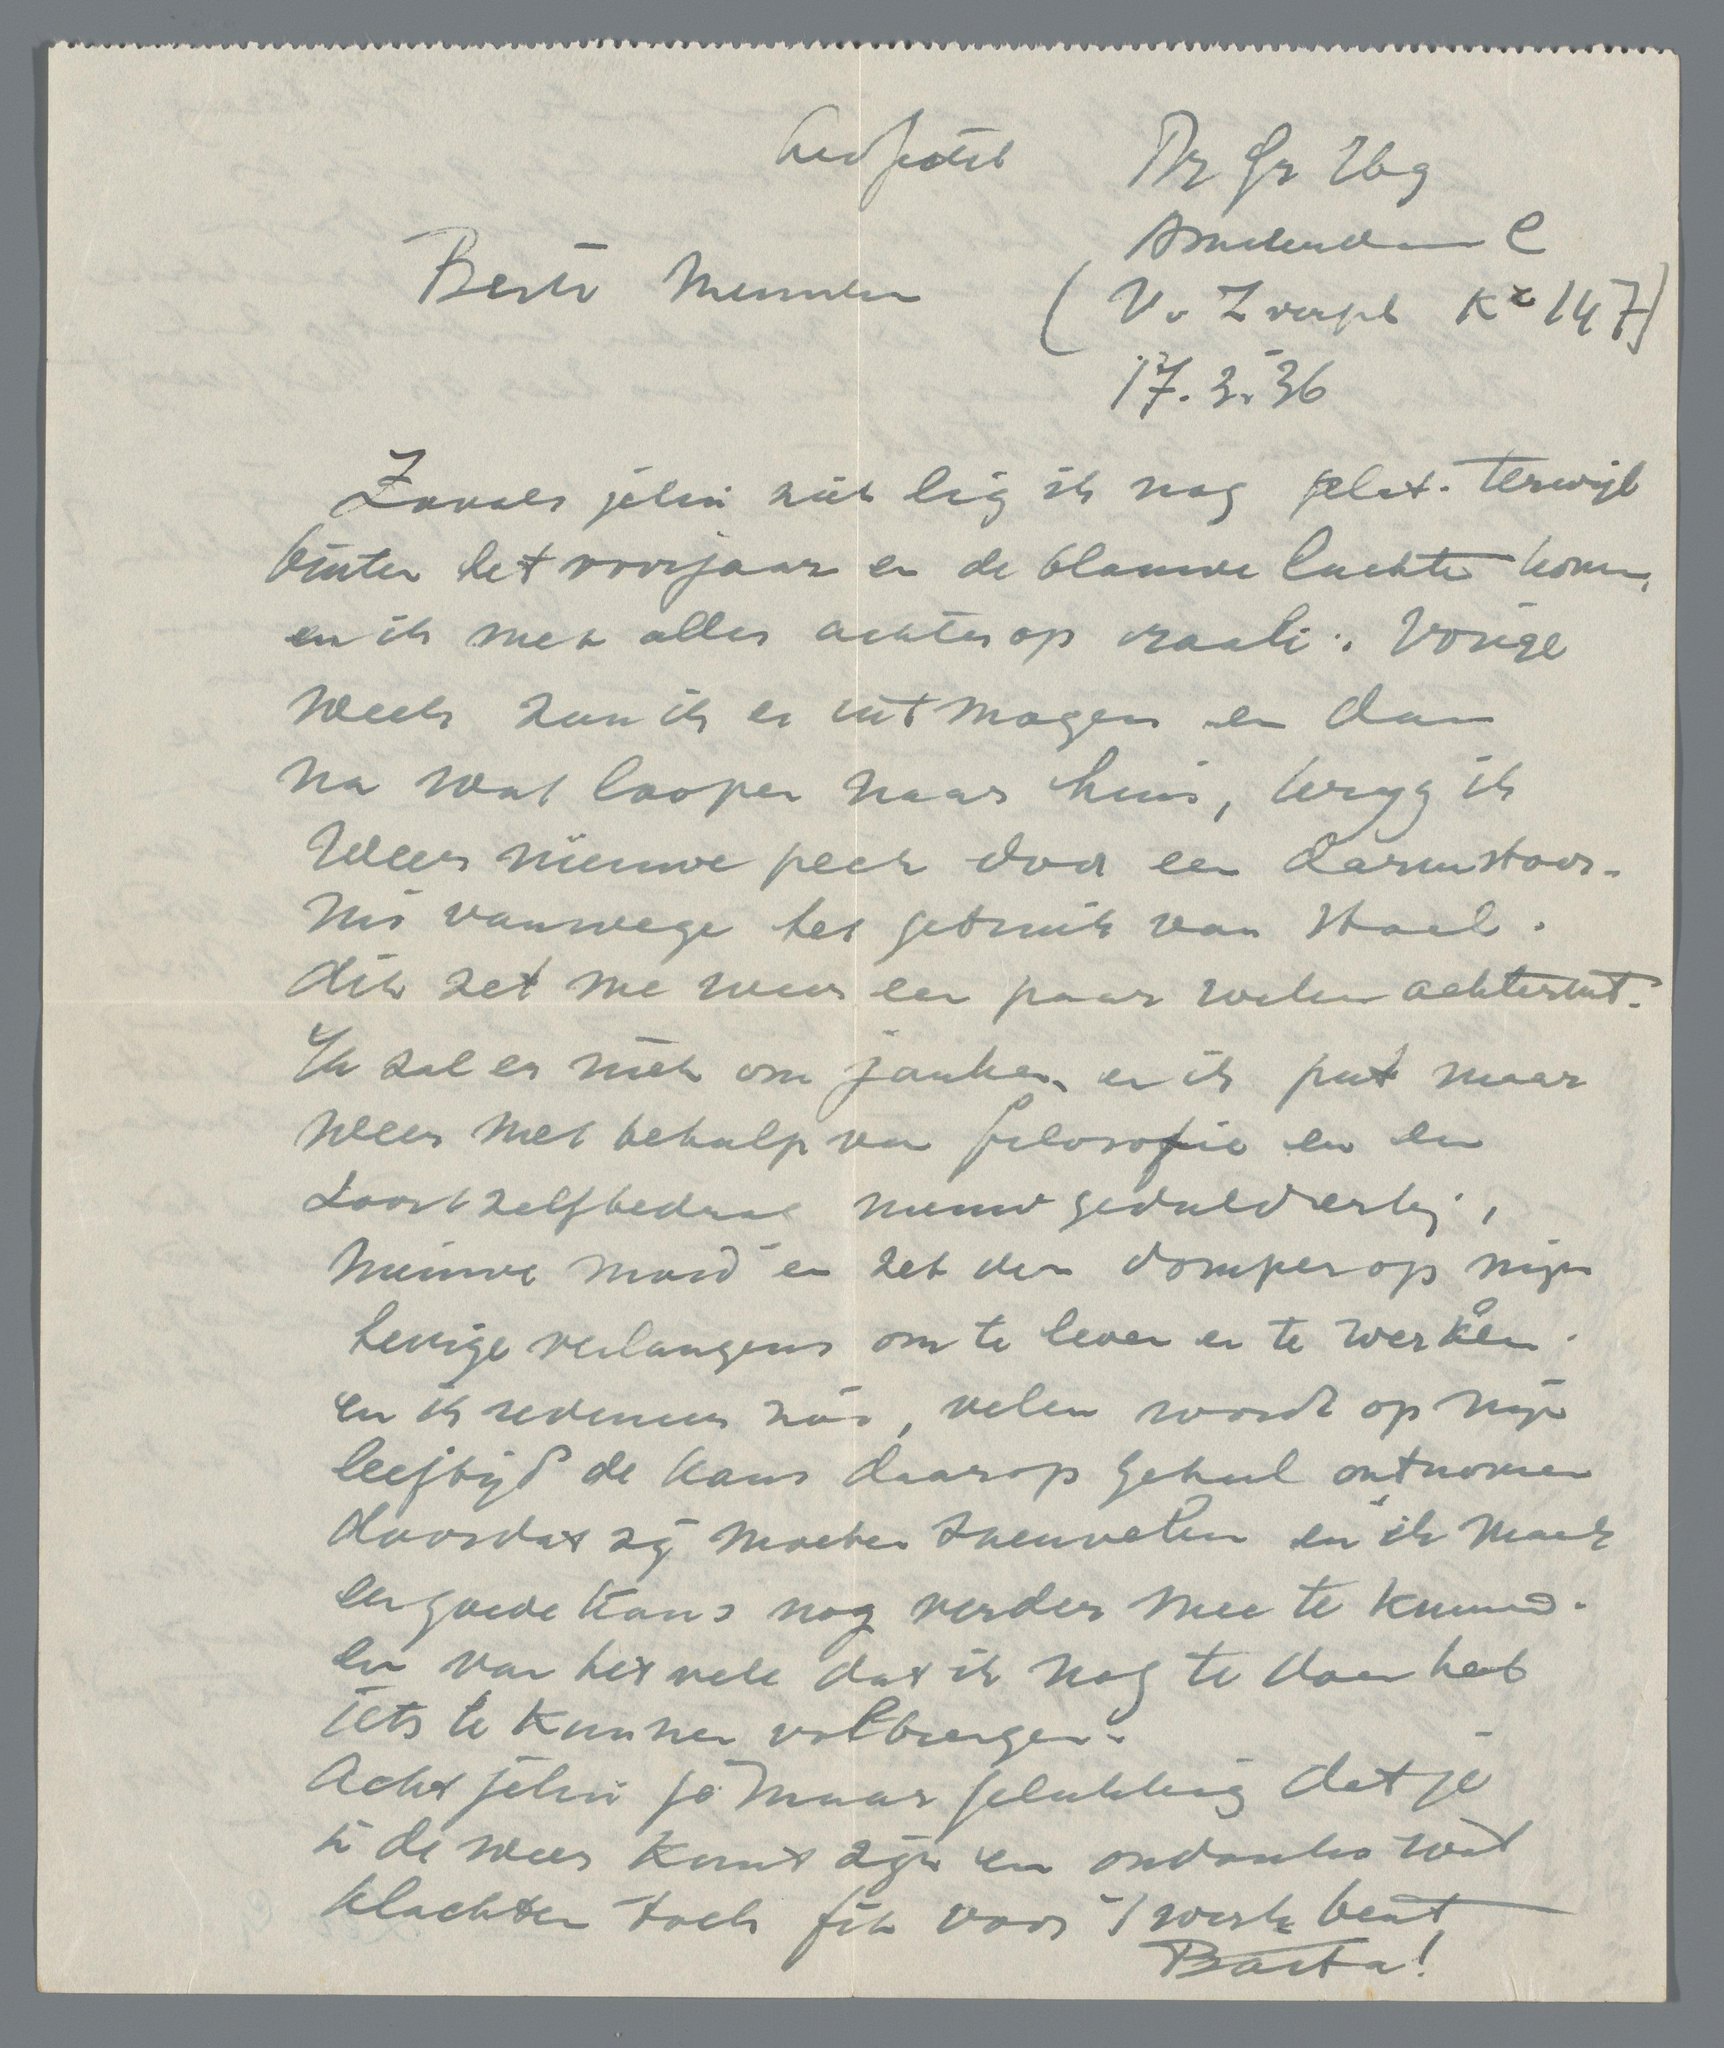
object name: letter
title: Brief aan Jan Ponstijn en Henriëtte Johanna Petronella van Hilten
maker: leo gestel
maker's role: draughtsman, print maker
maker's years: 1881-1941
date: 1936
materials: ink, paper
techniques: pen, writing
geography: amsterdam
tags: henriëtte johanna petronella ponstijn-van hilten, jan petrus ponstijn, recovery, convalescence of sick person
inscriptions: date